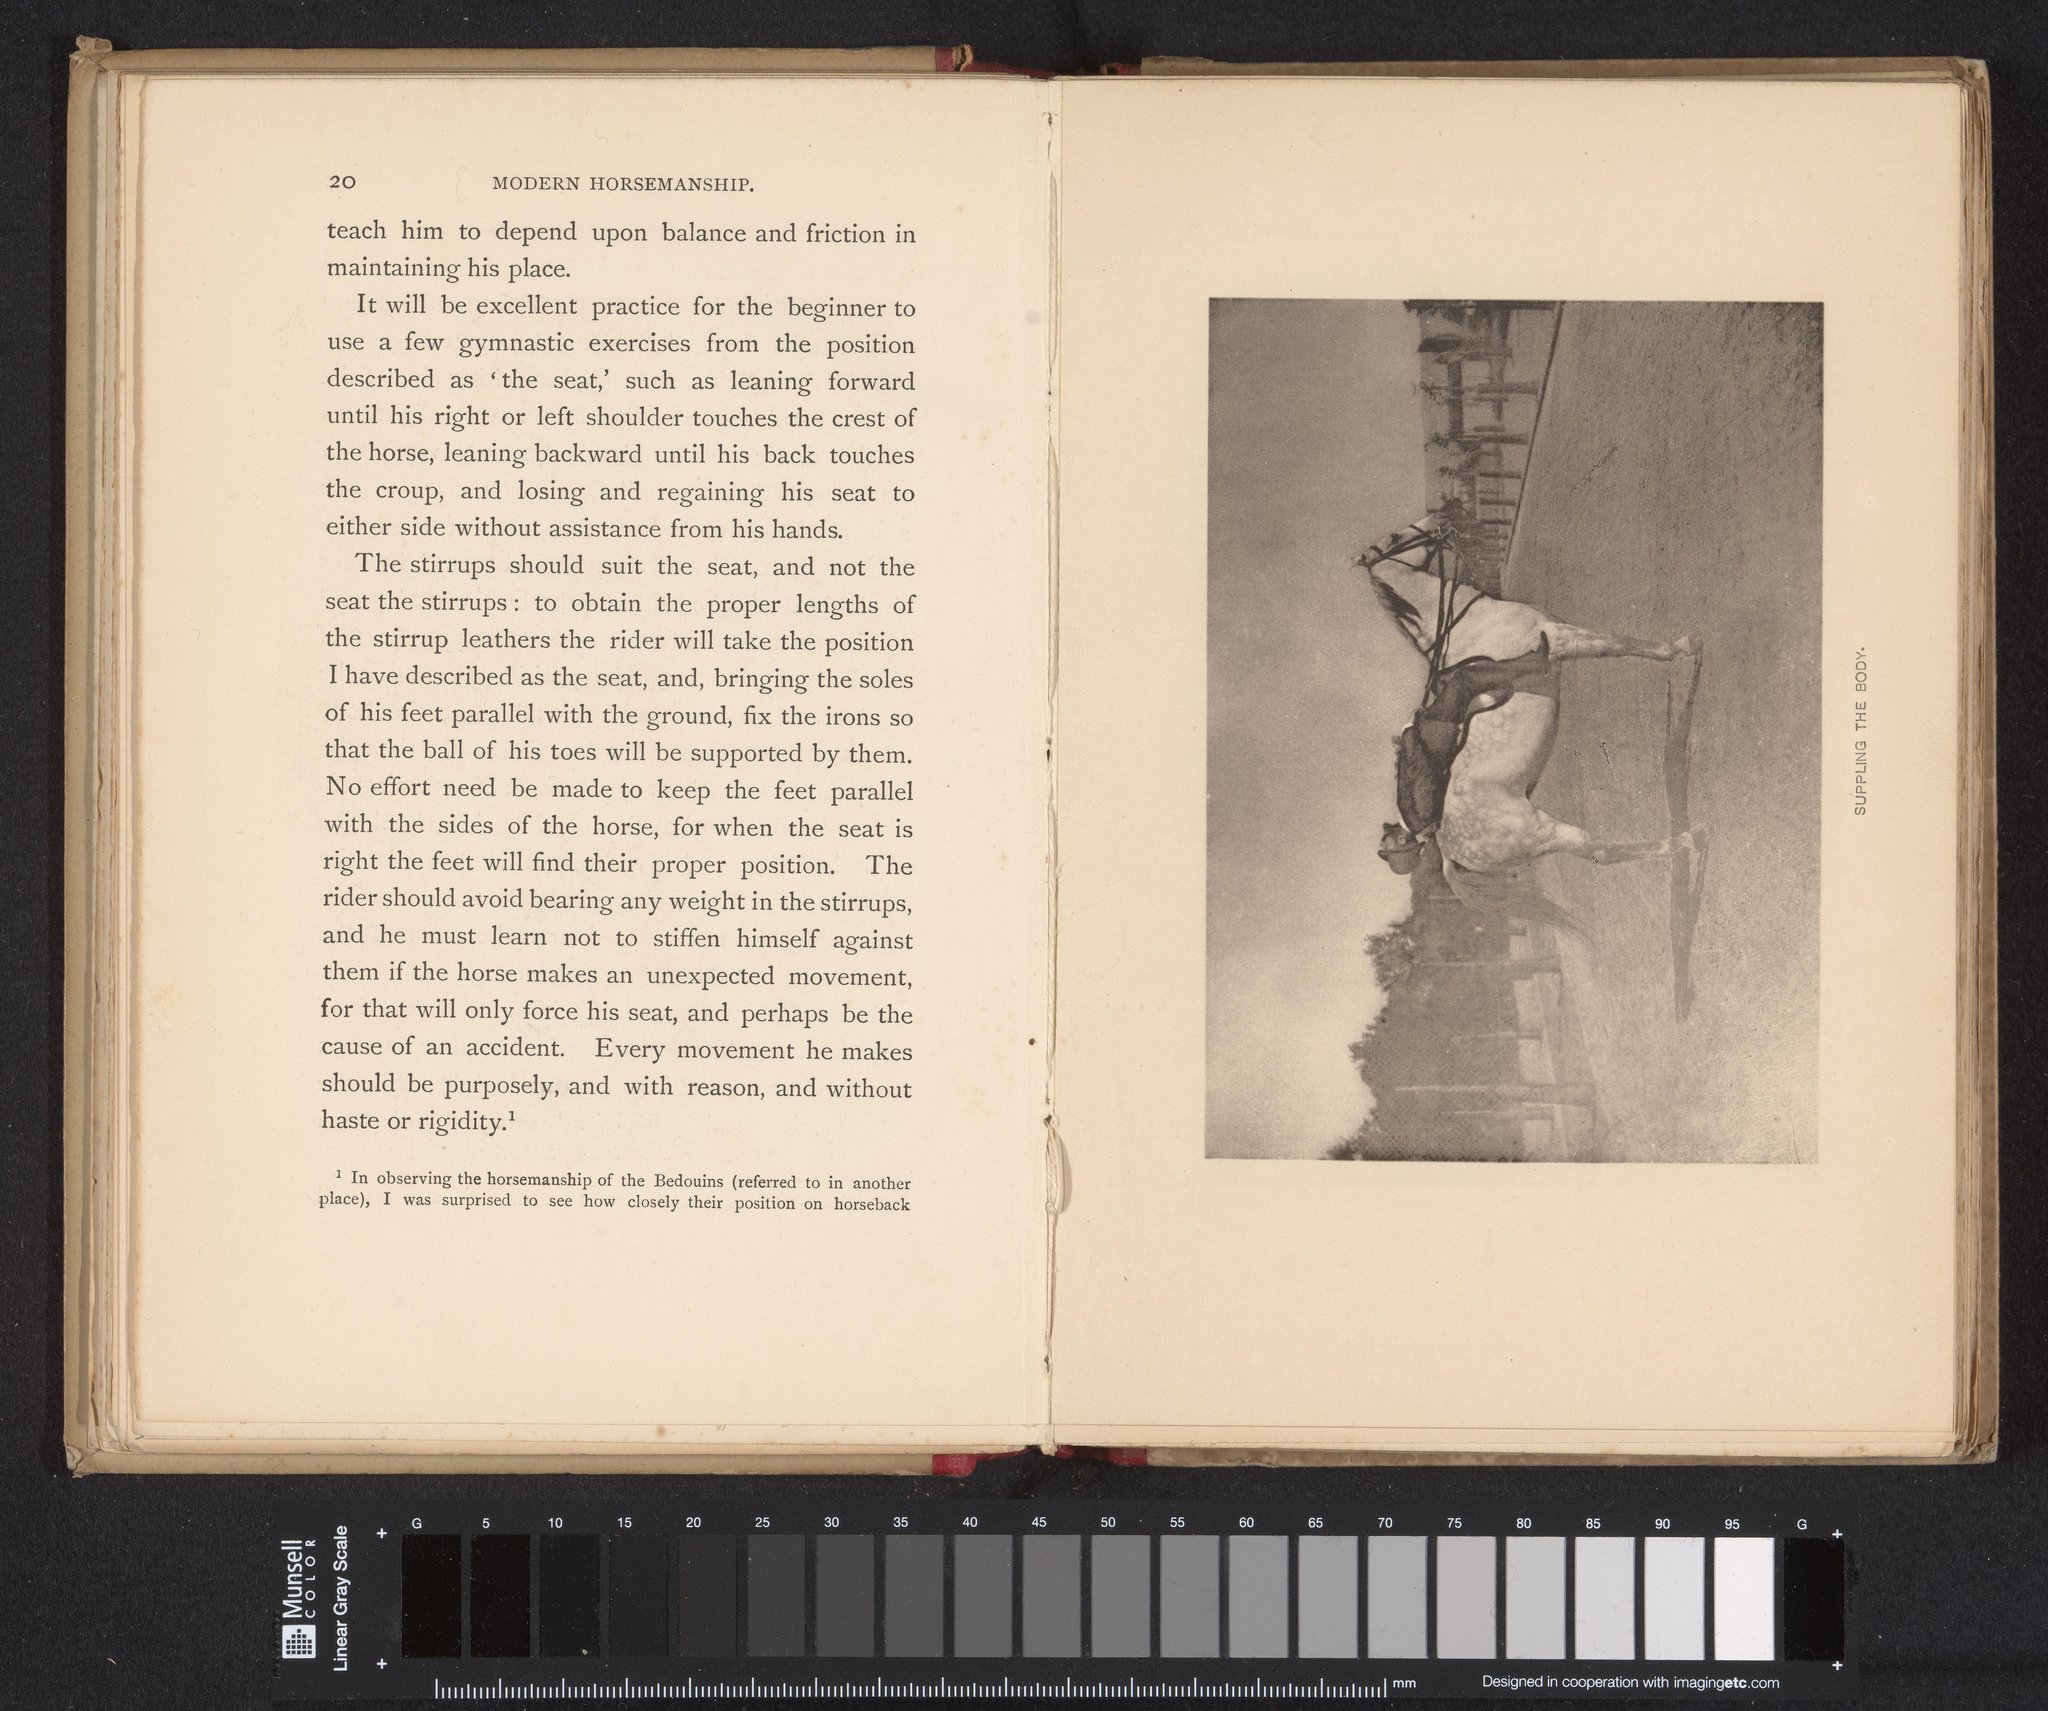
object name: page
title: Suppling the body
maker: Anonymous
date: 1879-1889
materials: paper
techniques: photograph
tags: riding a horse, ass, or mule; rider, horseman, head-gear: bowler hat, horse